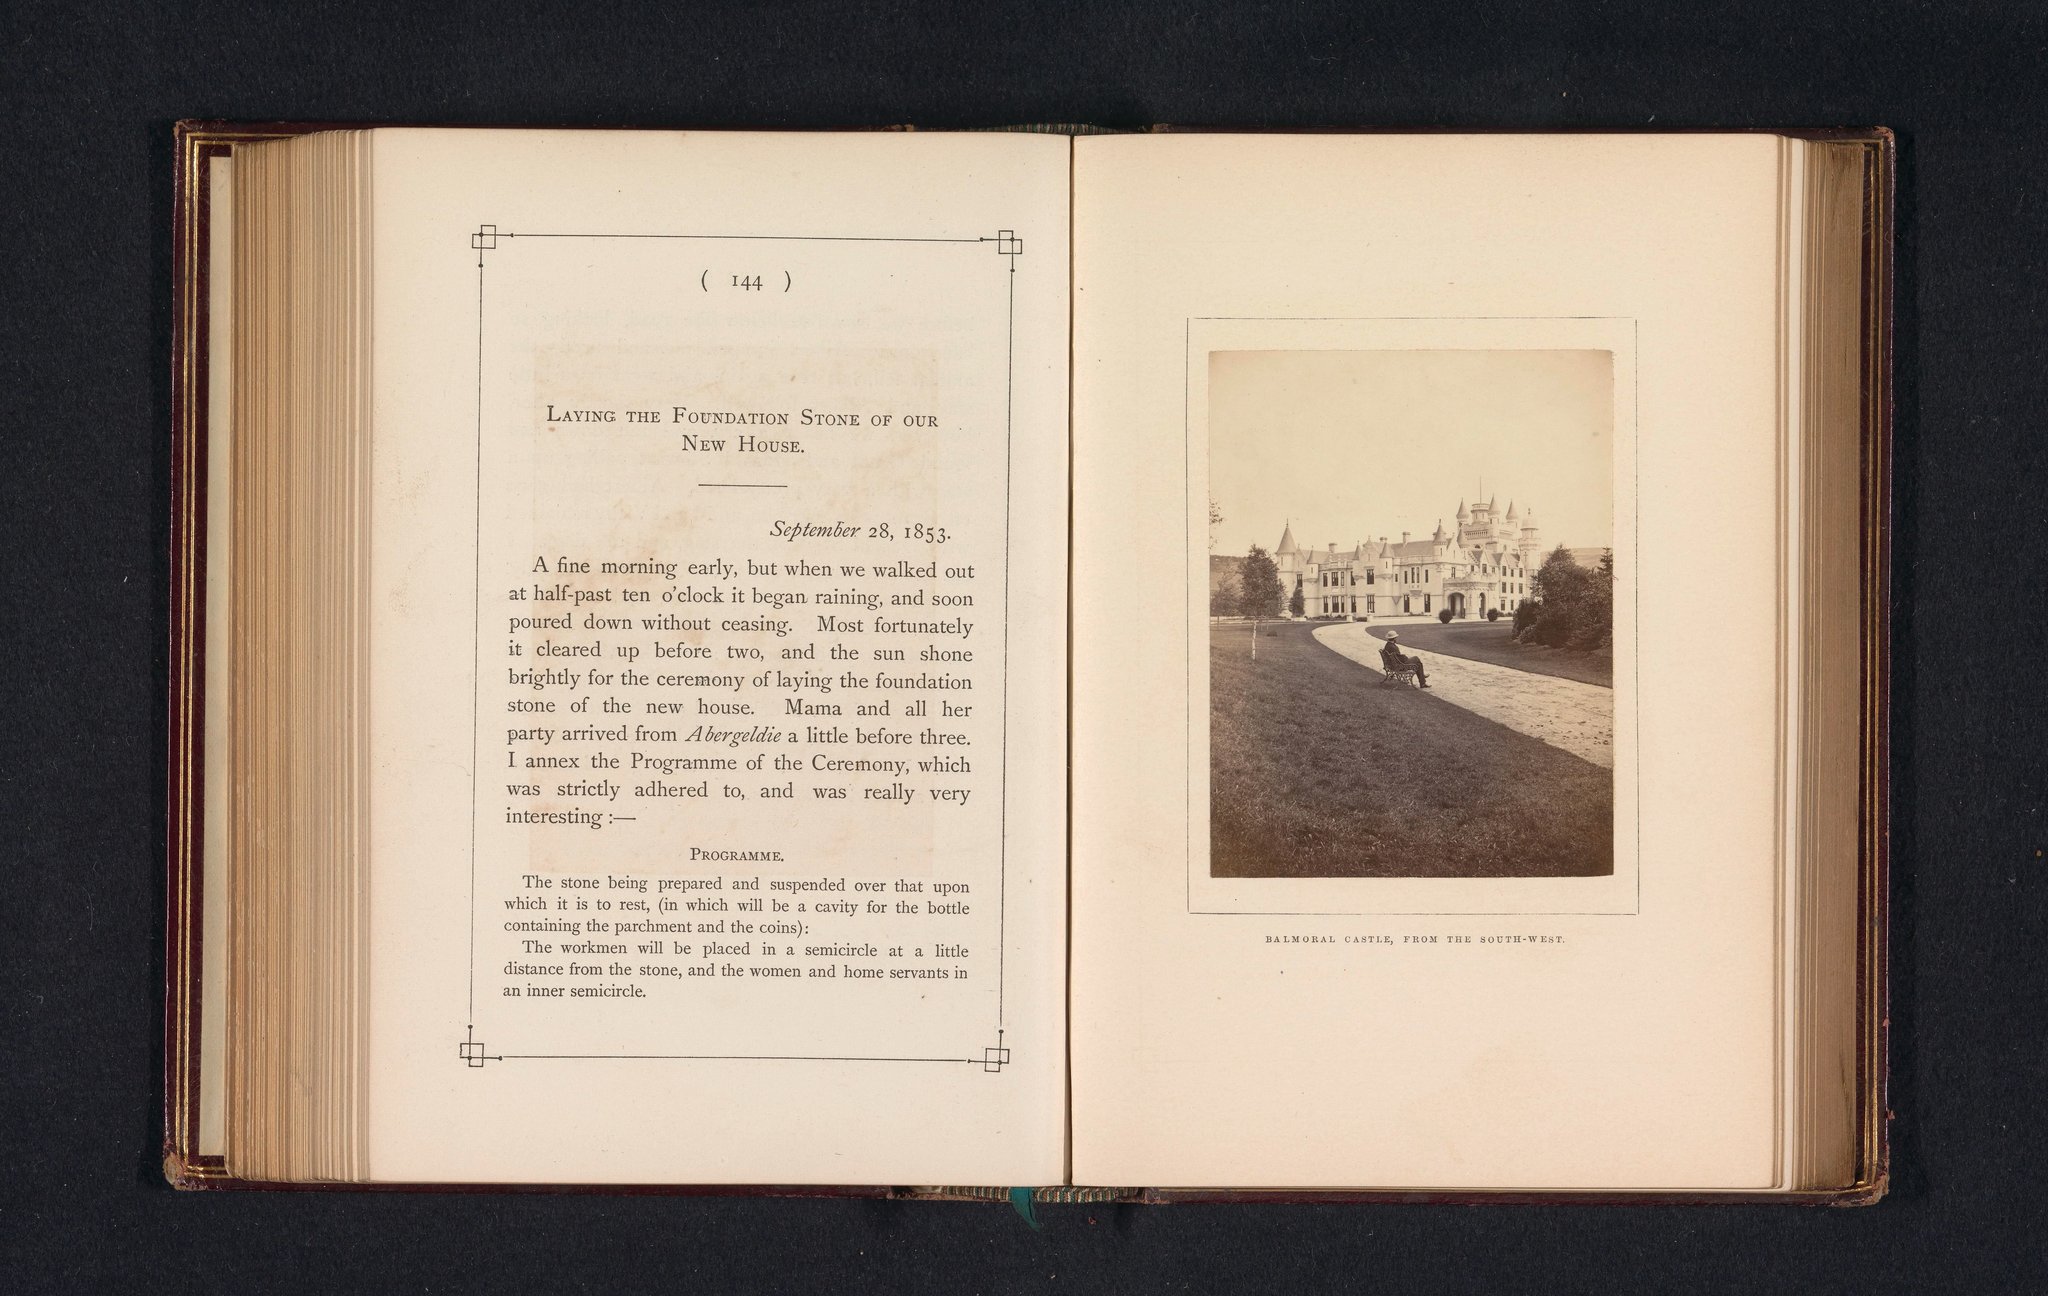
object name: photograph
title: Balmoral Castle, from the south-west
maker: george washington wilson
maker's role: publisher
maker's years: 1823-1893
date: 1858-1868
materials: photographic support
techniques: albumen print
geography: aberdeen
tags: castle